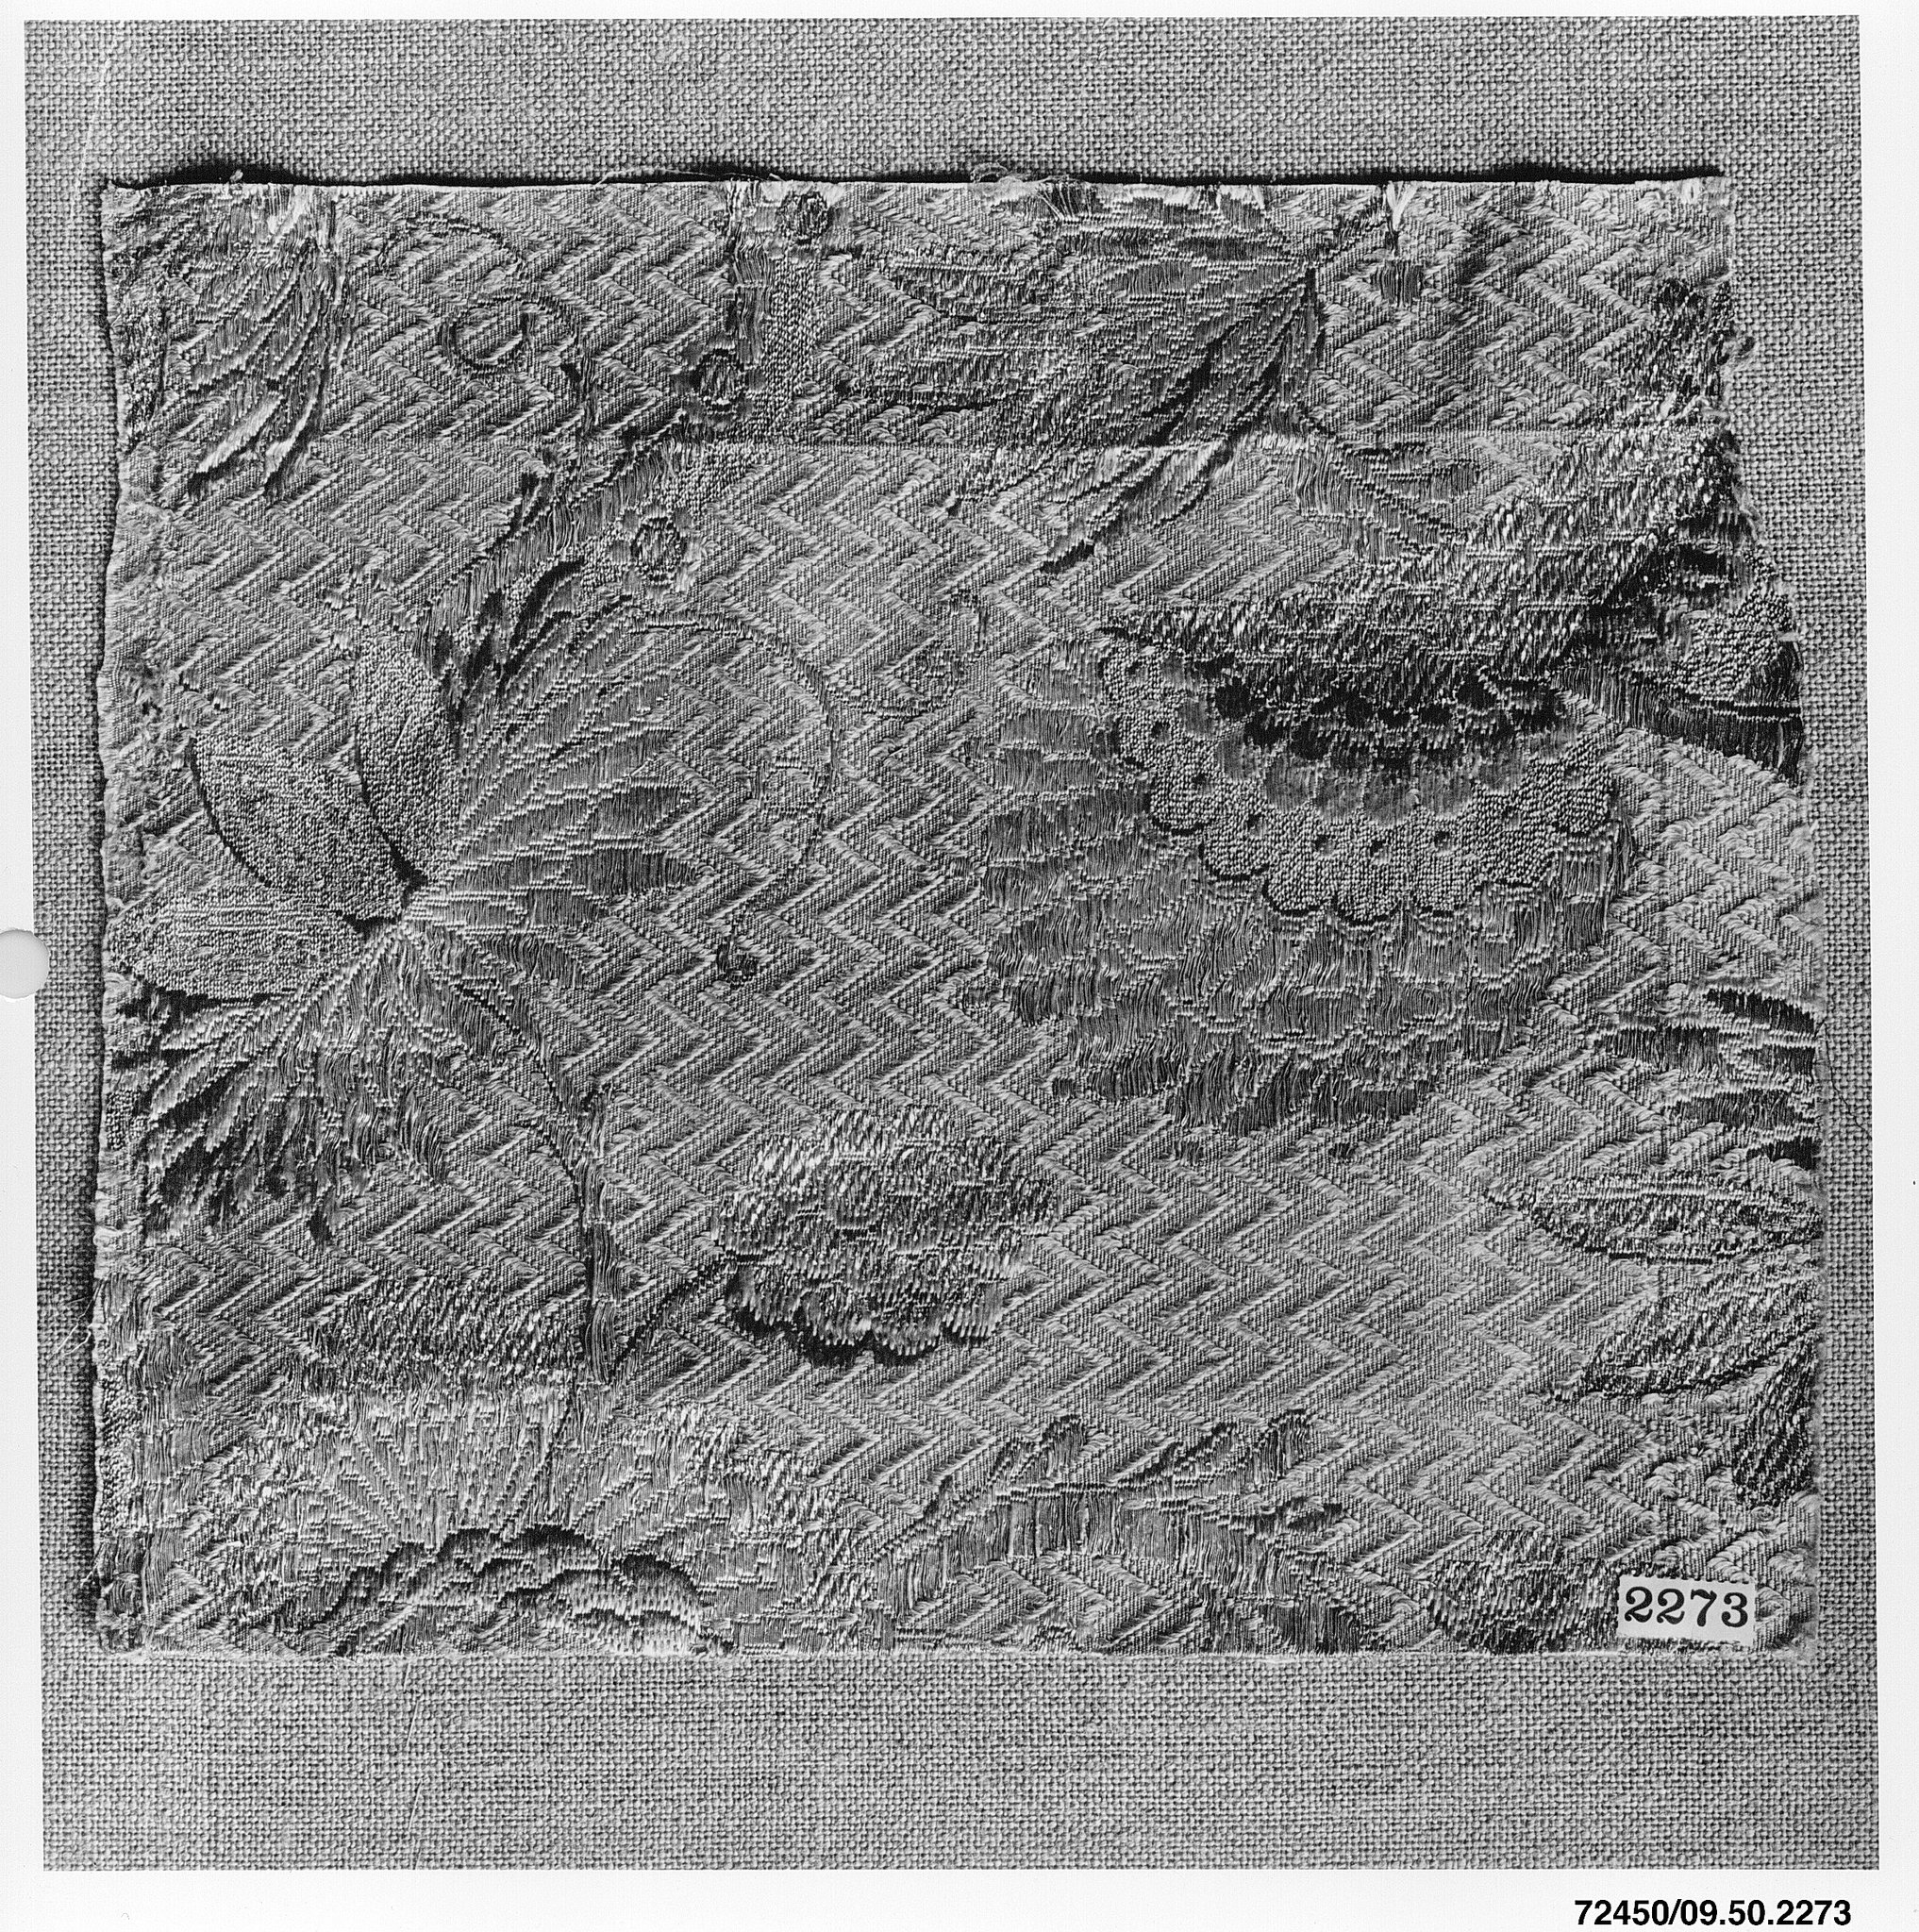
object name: brocade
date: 1760-1770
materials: metal thread, silk